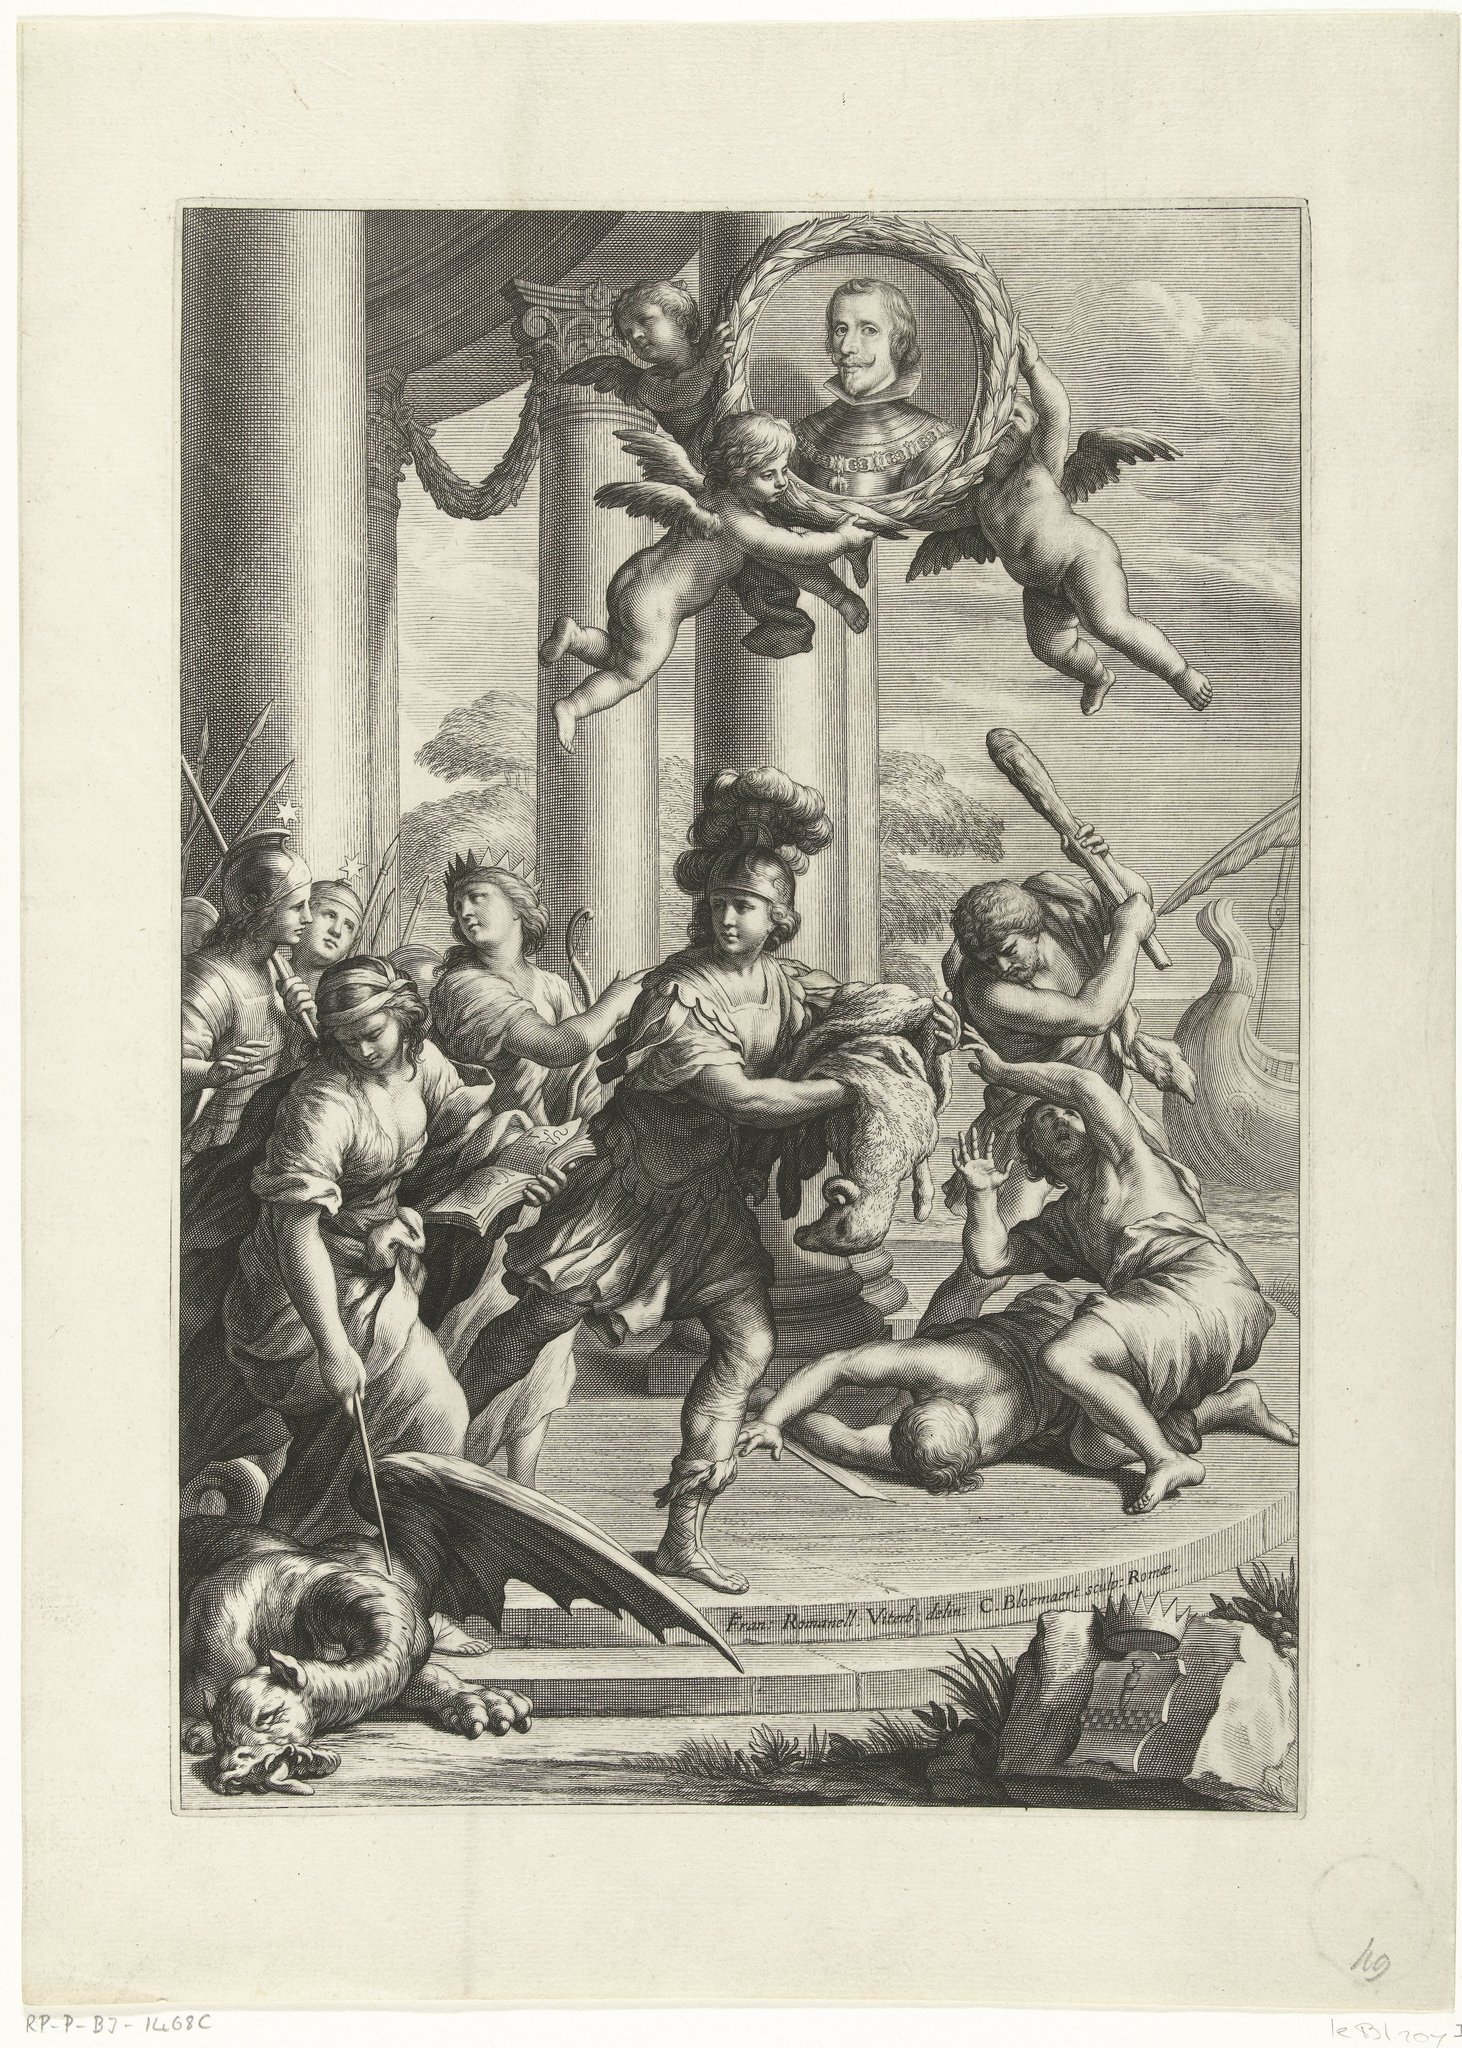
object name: print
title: Jason steelt het Gulden Vlies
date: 1633-1692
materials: paper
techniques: engraving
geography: rome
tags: filips iv (koning van spanje), medea, the golden fleece, hanging on an oak-tree, is seized by jason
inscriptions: collector's mark: Lugt 240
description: Jason, gekleed in wapenrusting, heeft het Gulden Vlies bemachtigd, Medea loopt achter hem. De dode draak kronkelt nog na. Drie putti houden een portret van Filips IV van Spanje, hij draagt de ketting van de Orde van het Gulden Vlies. Rechts voor zijn koninklijk wapen.